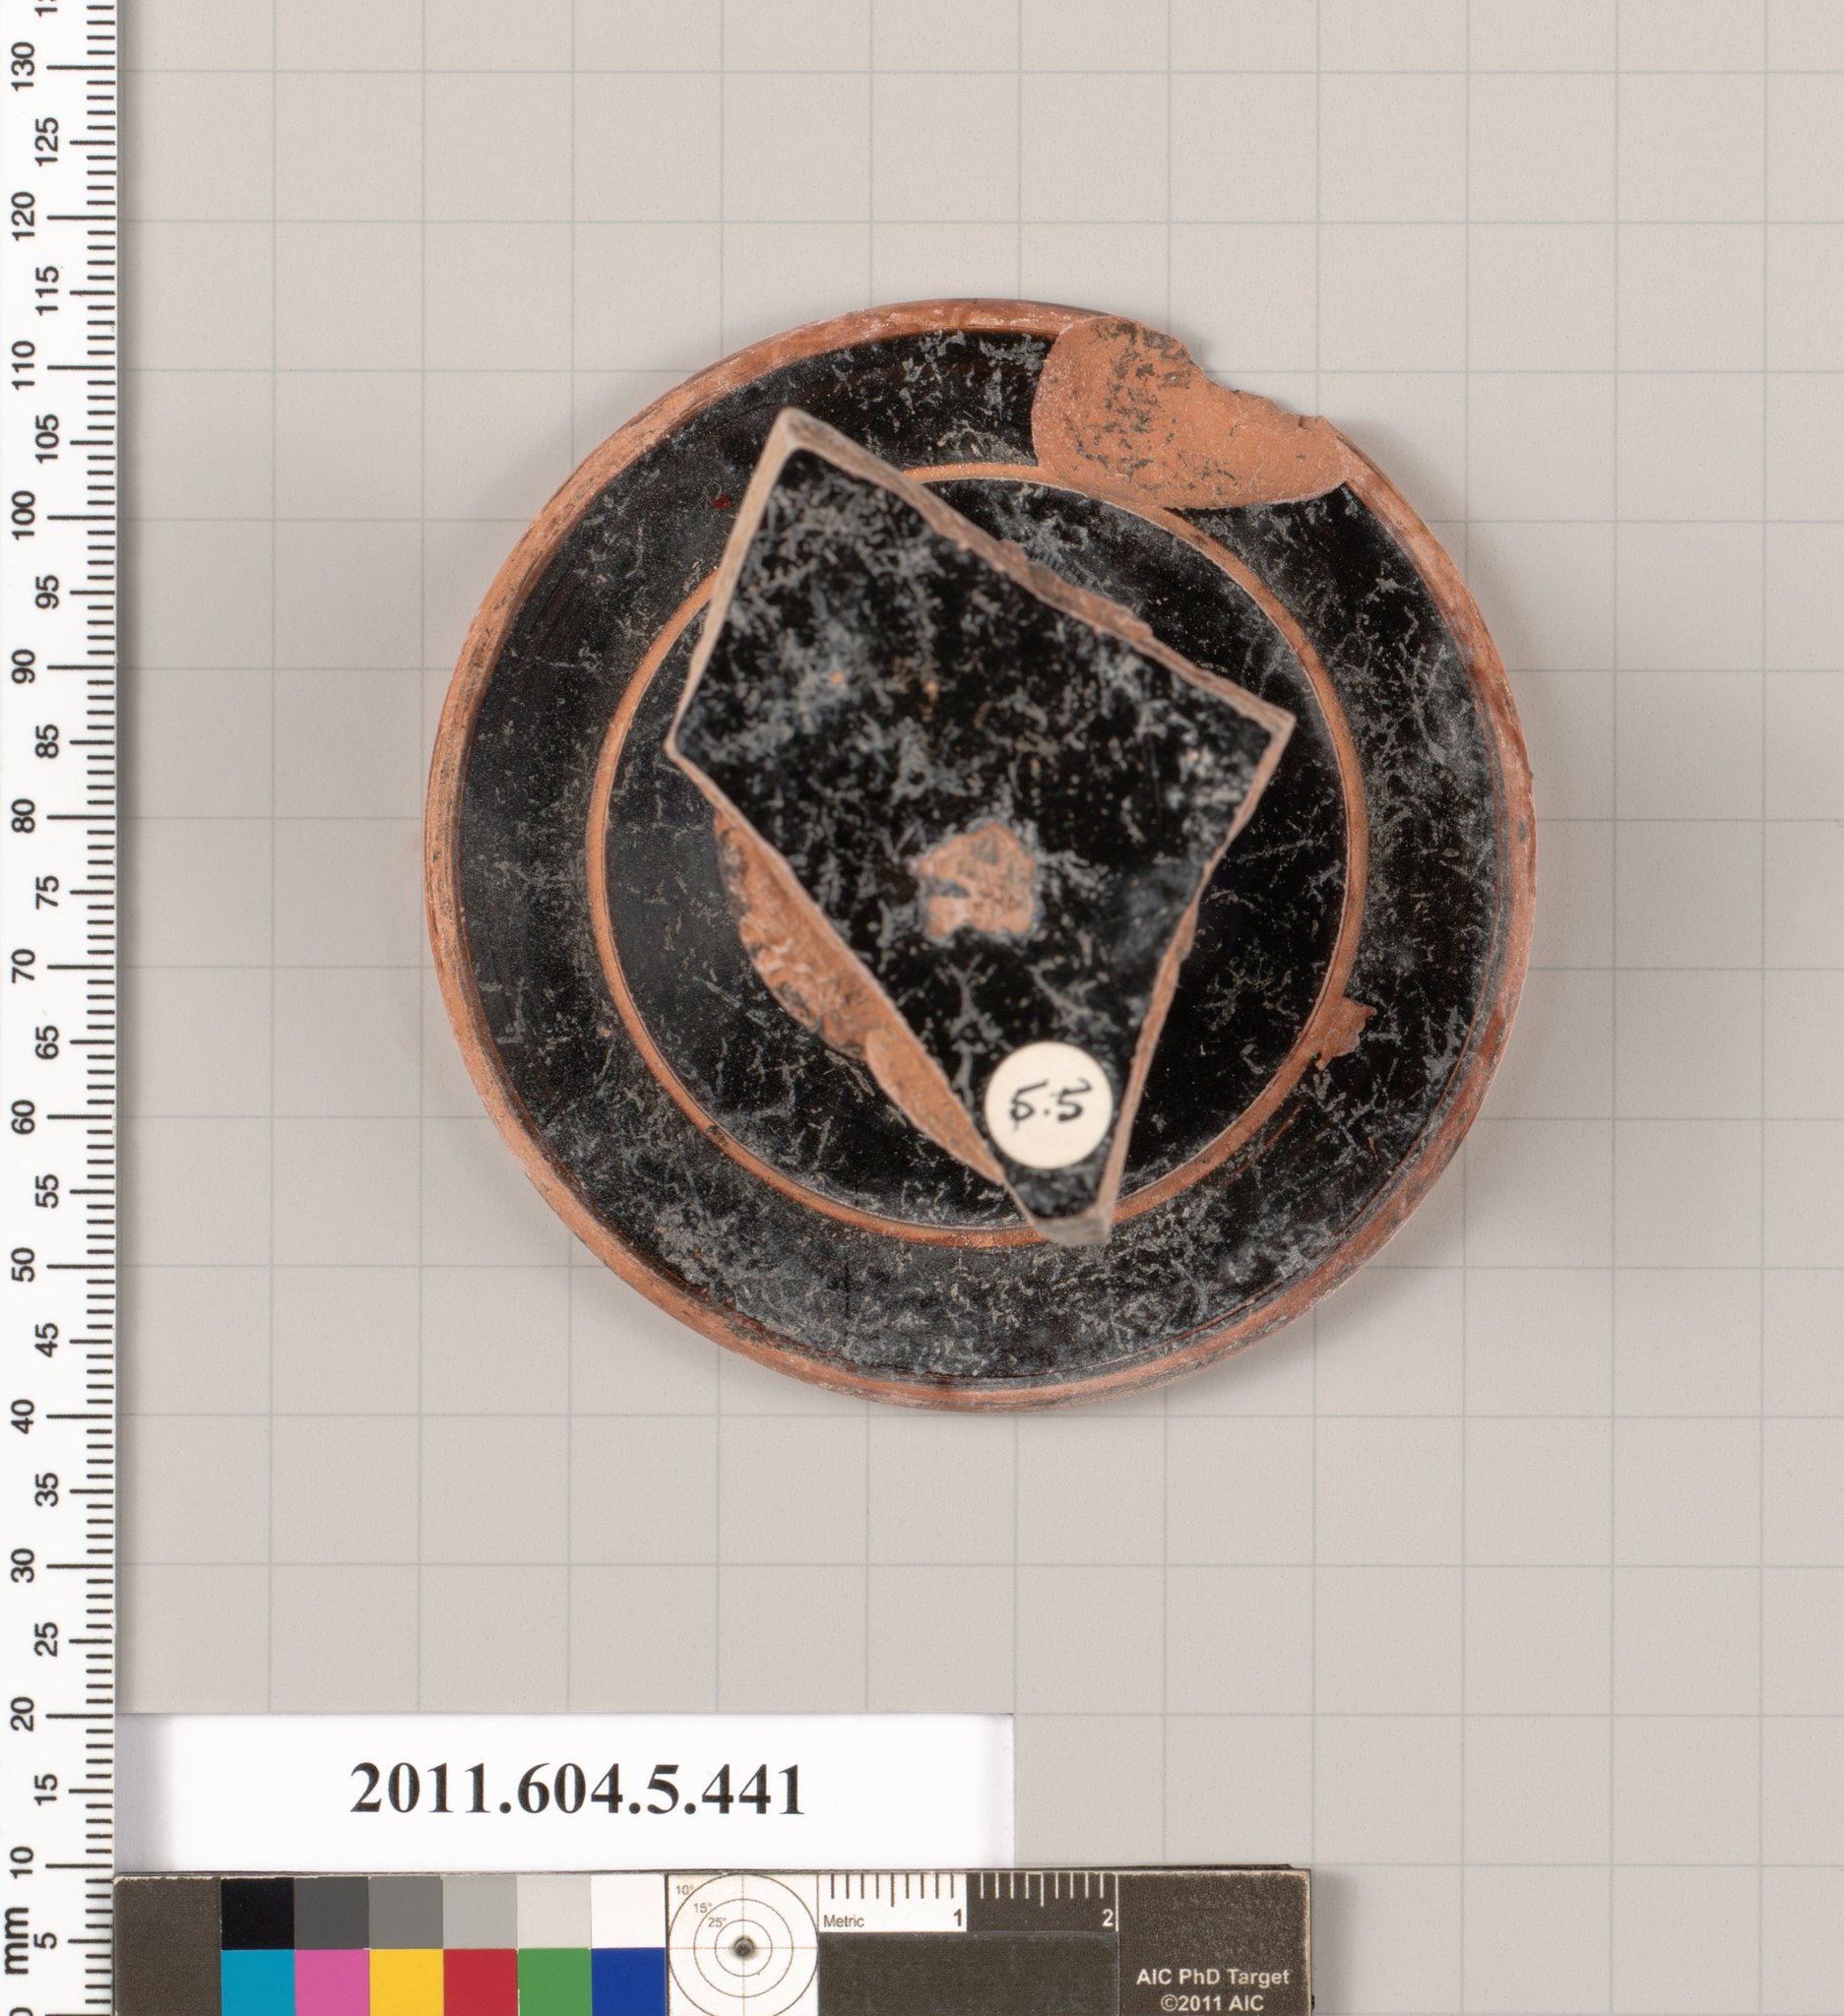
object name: kylix fragment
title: Terracotta fragment of a kylix (drinking cup)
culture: greek, attic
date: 600-401 BCE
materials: terracotta